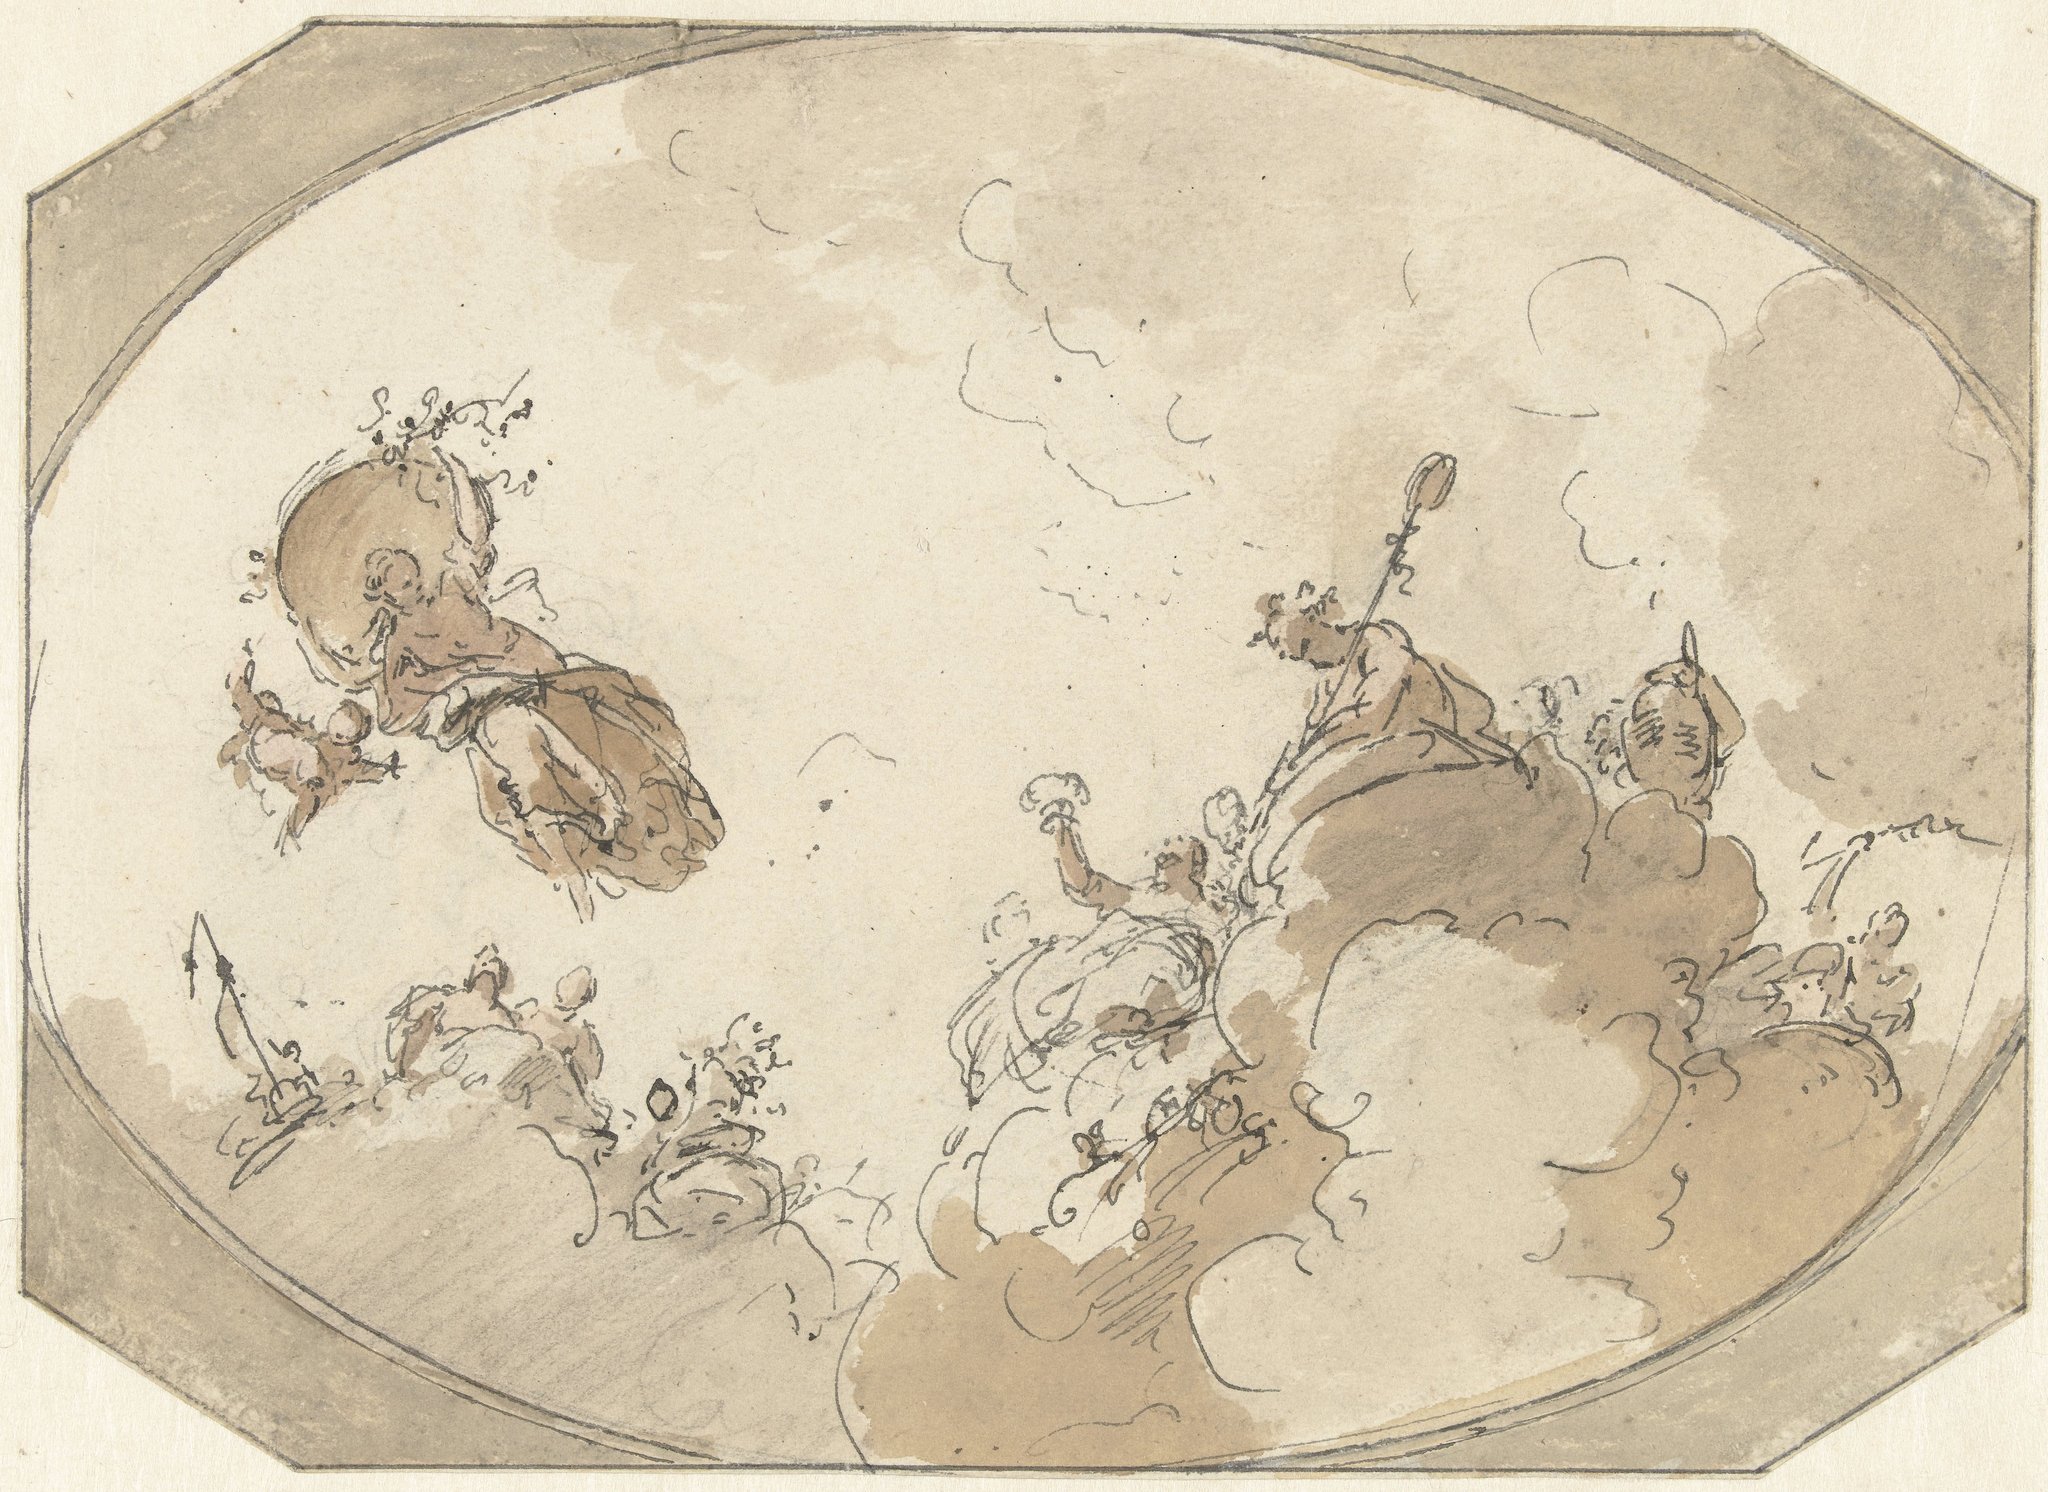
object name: design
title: Ontwerp voor plafondschildering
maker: jacob de wit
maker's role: draughtsman, painter, print maker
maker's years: 1695-1754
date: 1705-1754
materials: ink, paper, pencil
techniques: brush, pen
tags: flying, sitting or standing on clouds